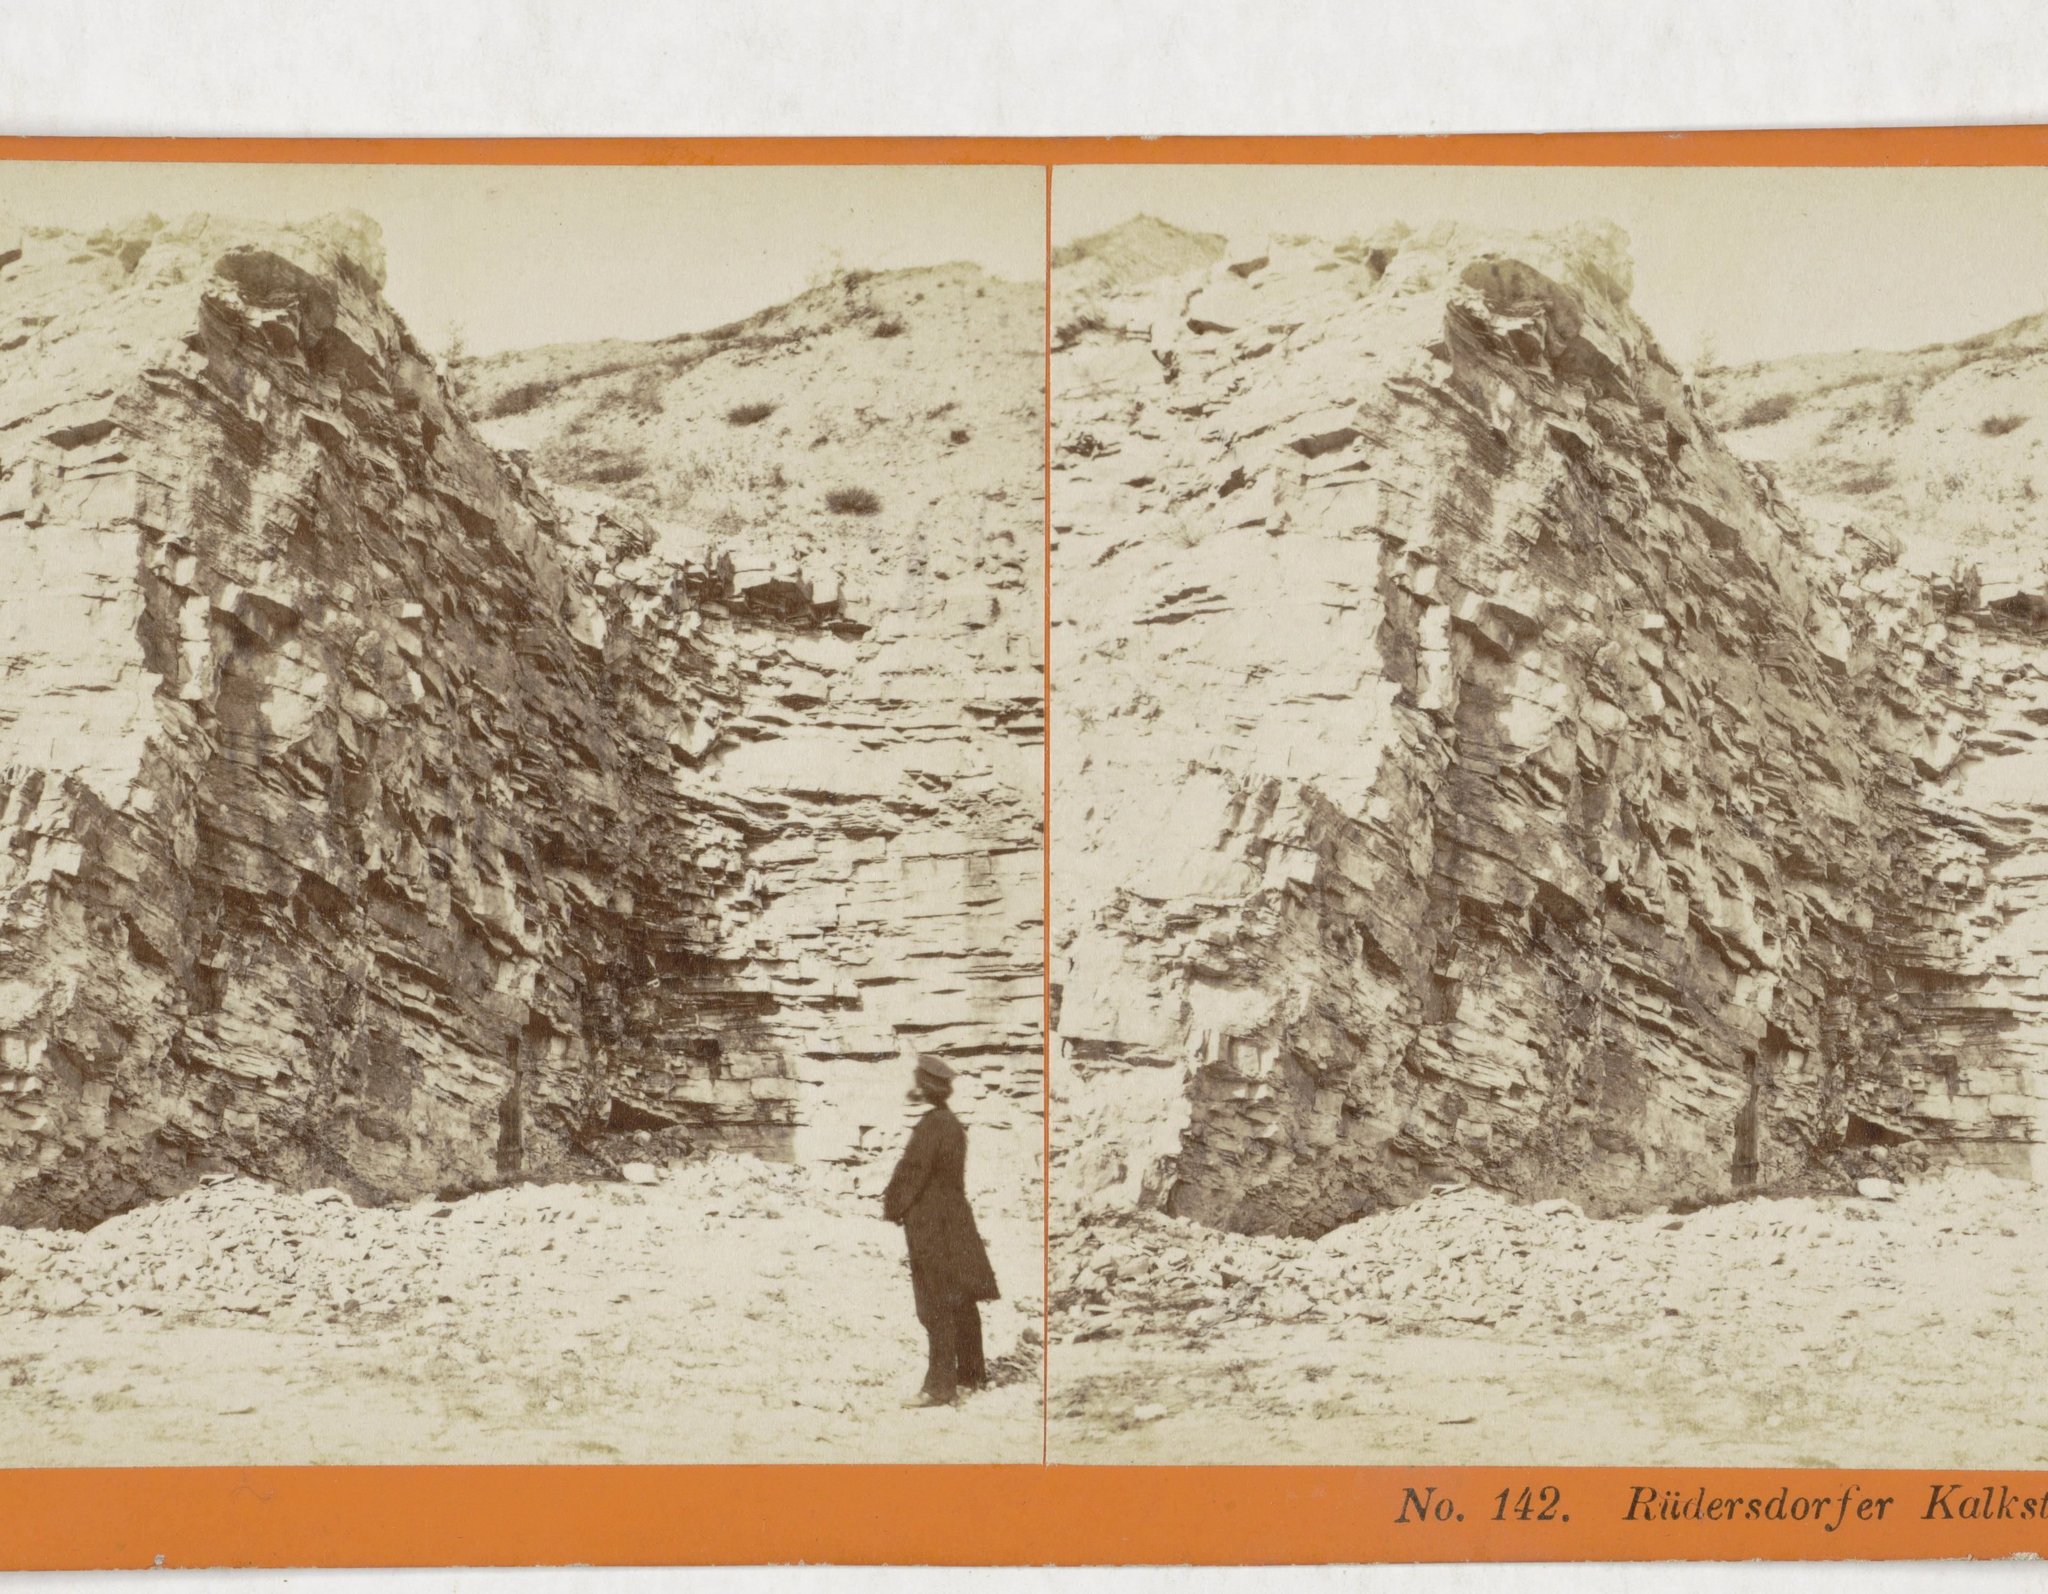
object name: stereograph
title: Man in de kalksteengroeve van Rüdersdorf, nabij Berlijn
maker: johann friedrich stiehm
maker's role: fotograaf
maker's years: 1826-1902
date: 1868-1870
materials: cardboard, paper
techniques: albumen print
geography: berlin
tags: quarry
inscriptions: number: ‘No. 142.’